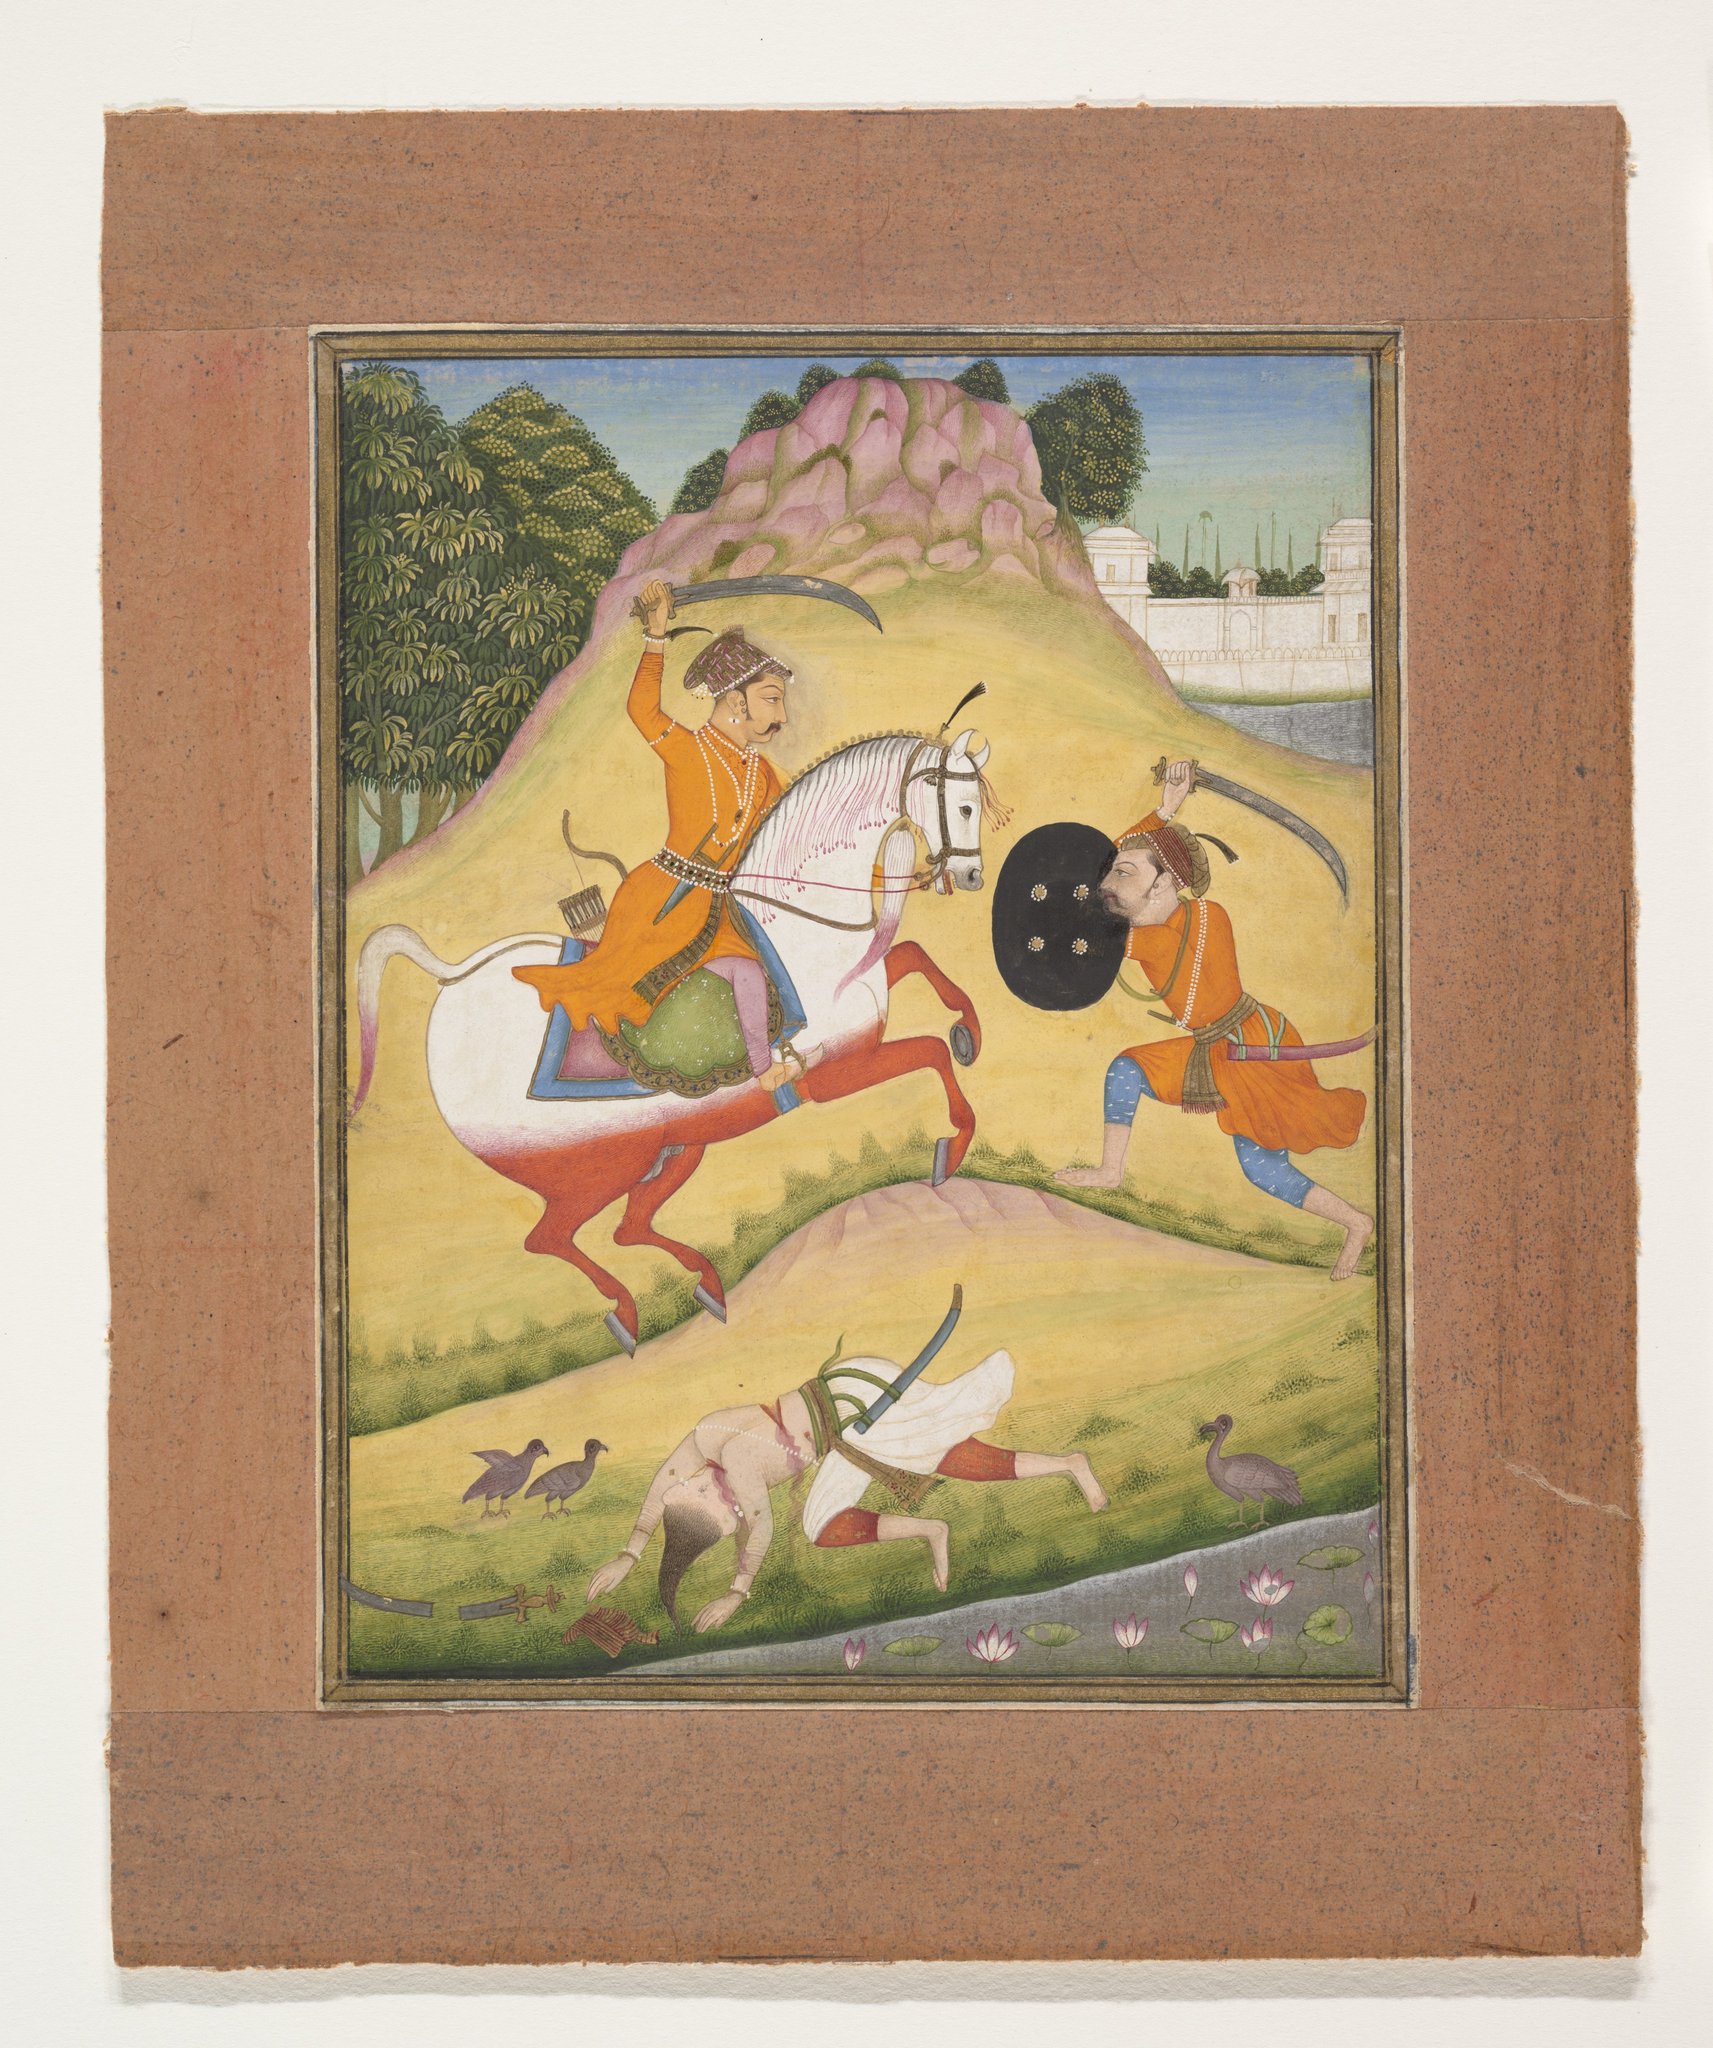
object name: folio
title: Nata Ragina: Folio from a ragamala series (Garland of Musical Modes)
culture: indian, rajasthani, bikaner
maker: mohamed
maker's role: artist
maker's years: 1700-1733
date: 1714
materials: ink, paper, watercolor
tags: battles,swords,men,horses,death